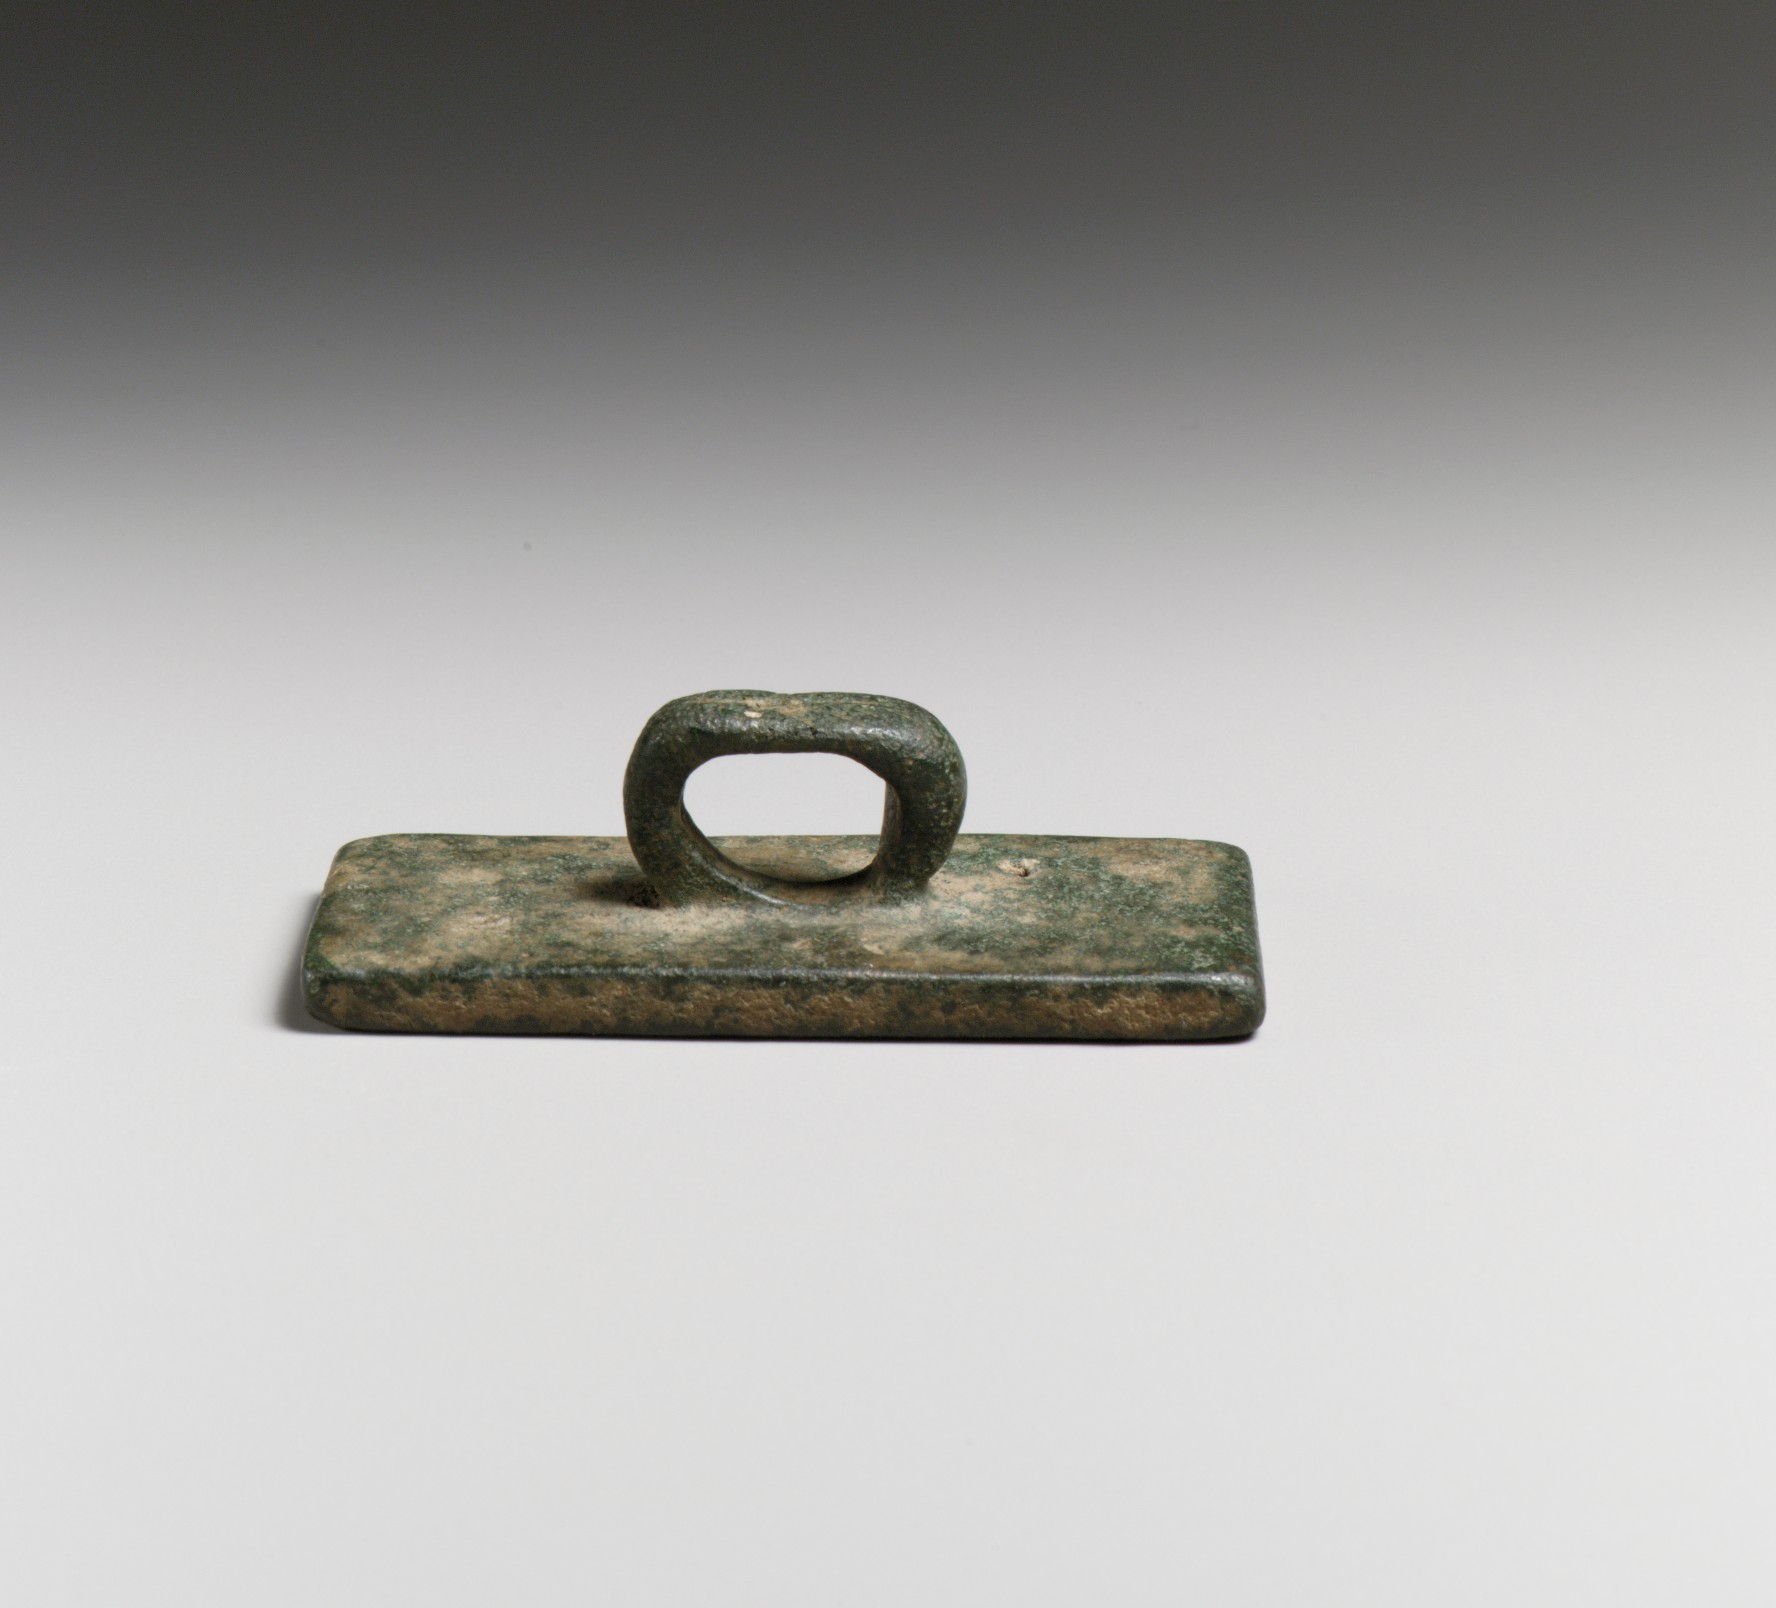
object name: stamp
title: Bronze stamp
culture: roman, asia minor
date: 1-100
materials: bronze